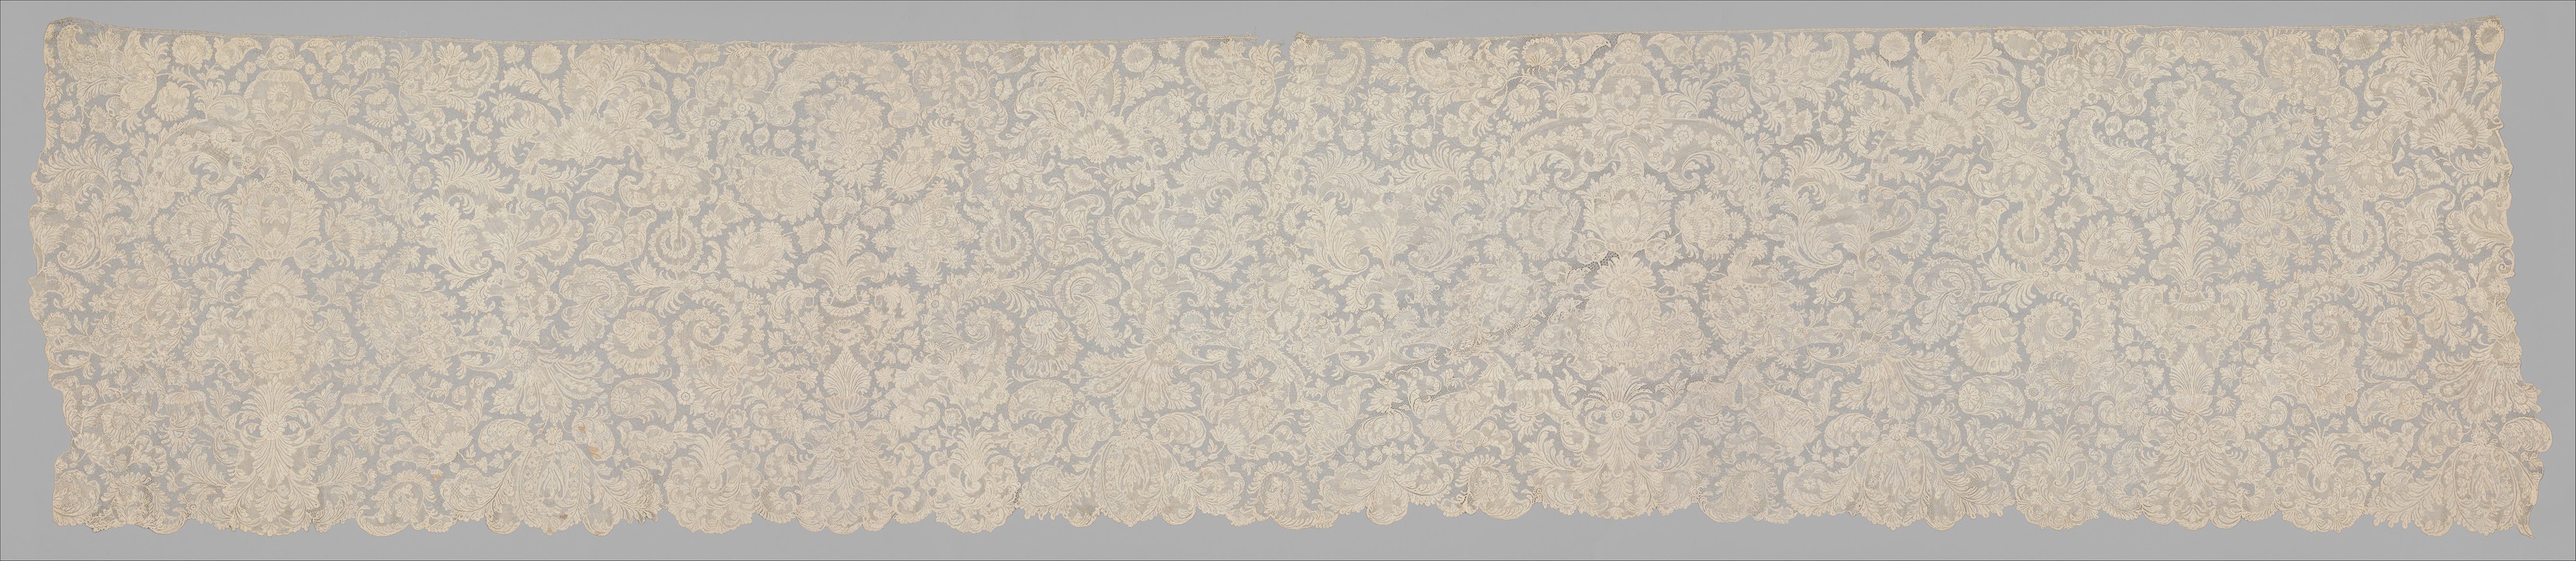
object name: flounce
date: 1701-1750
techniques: lace